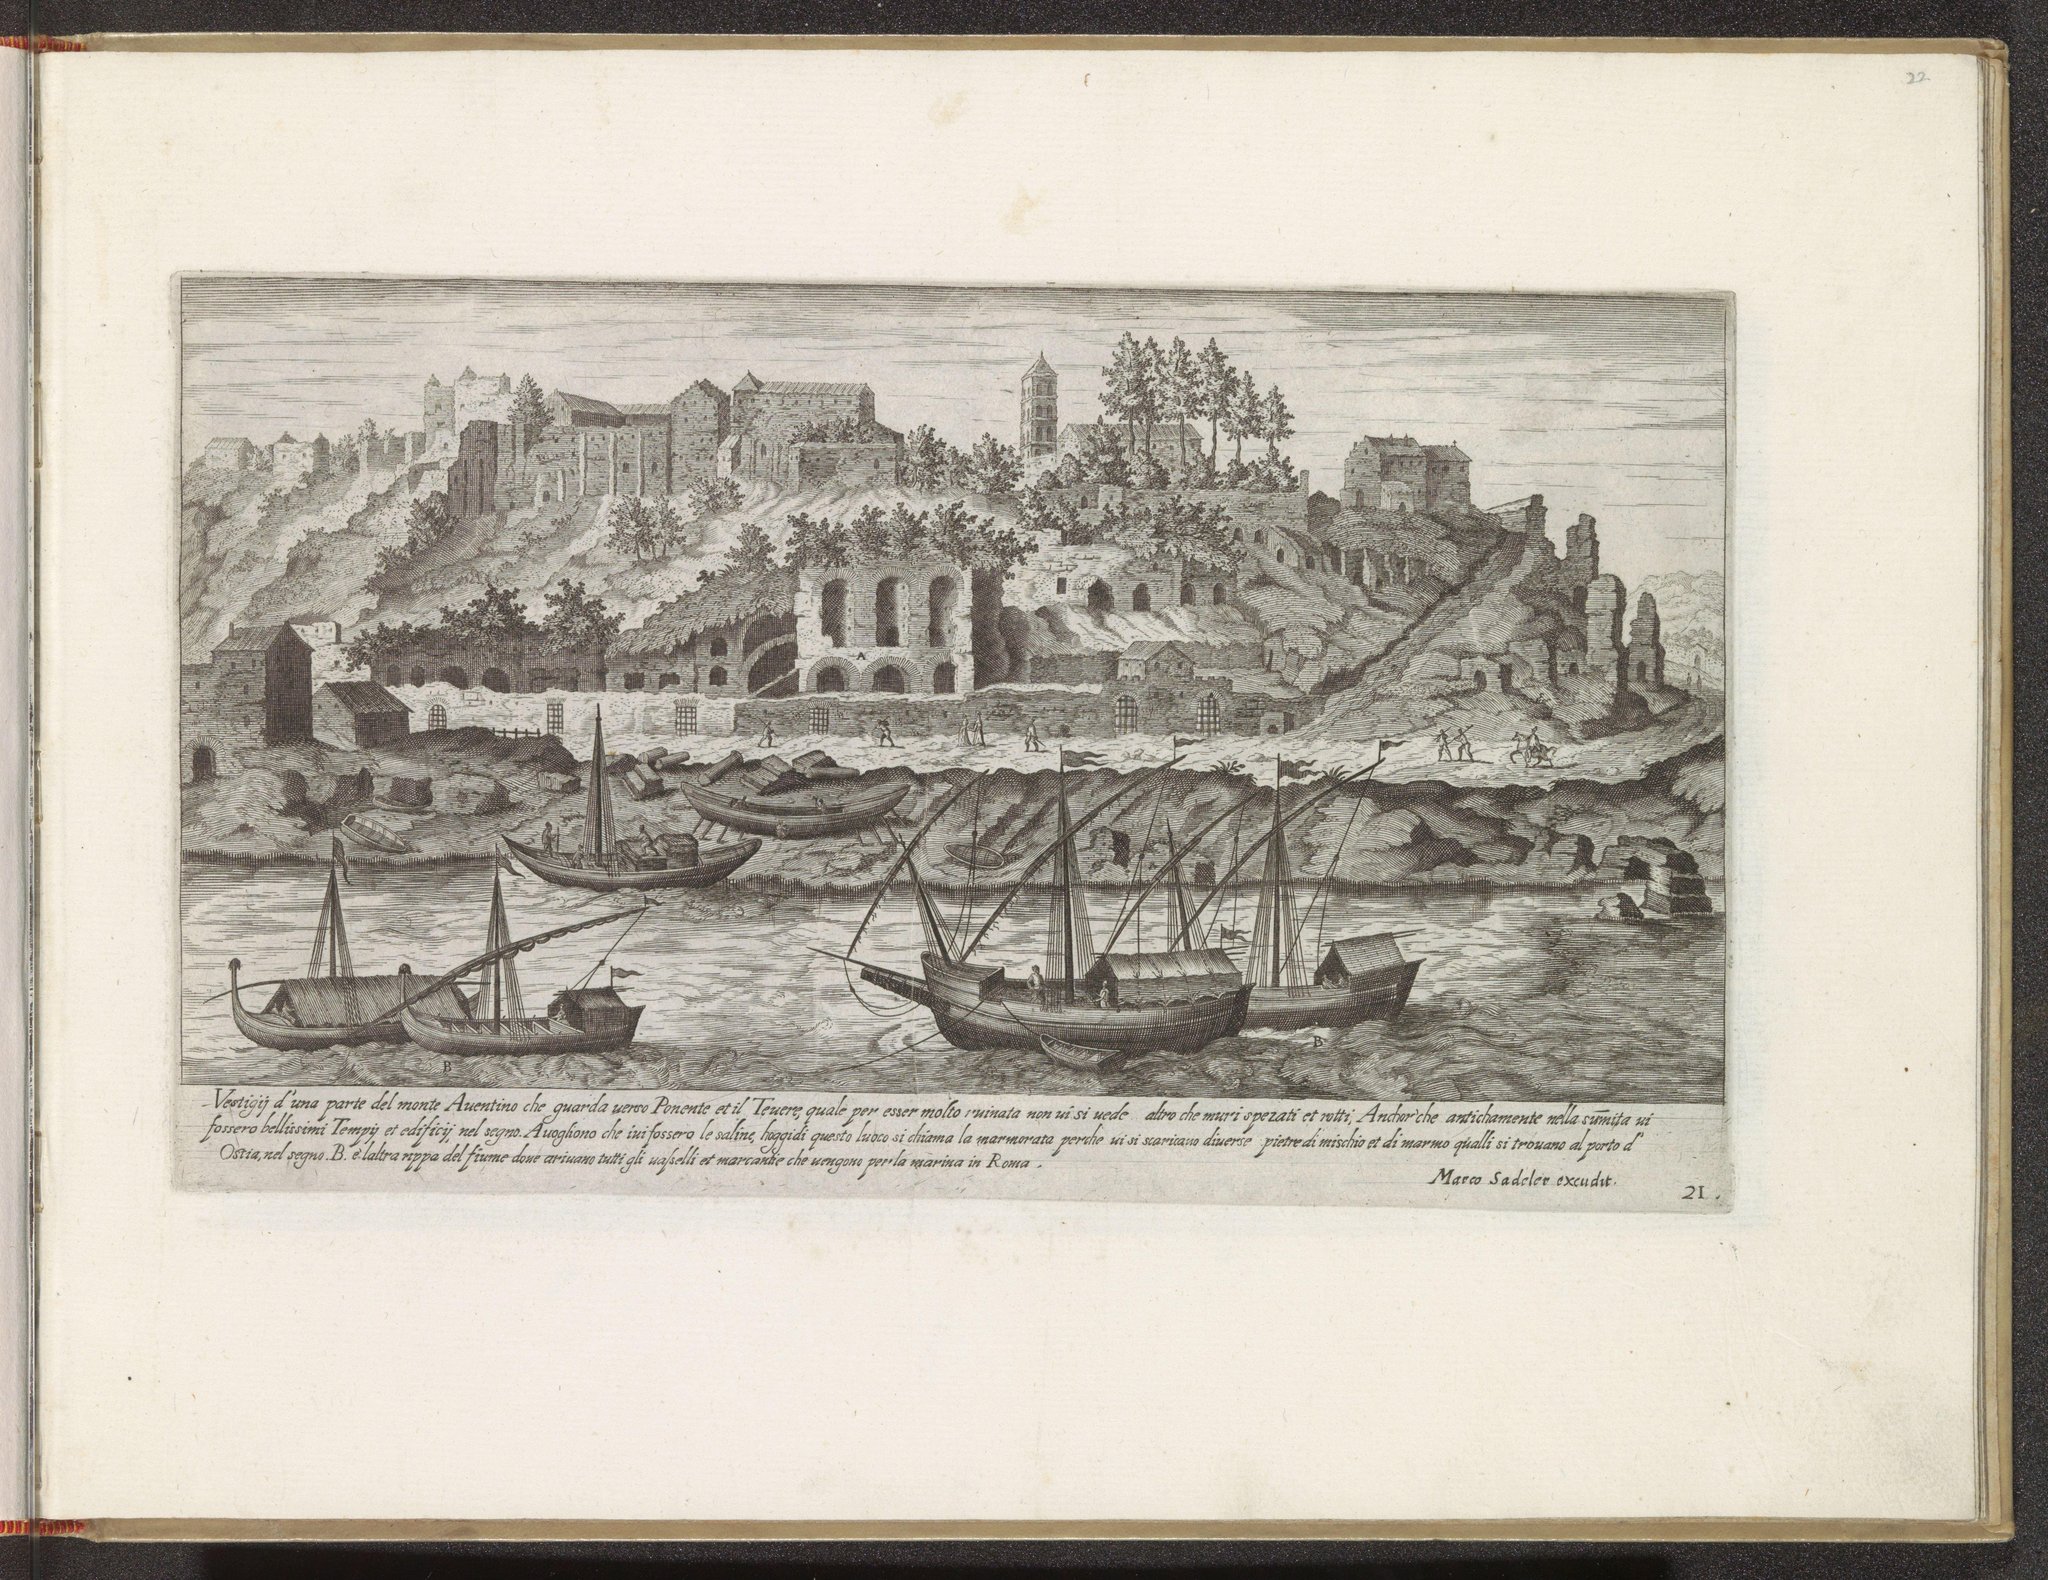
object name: print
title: Vestigi della antichita di Roma, Tivoli, Pozzuolo et altri Luochi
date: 1606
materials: paper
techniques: engraving, etching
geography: prague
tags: rome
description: Overblijfselen van de gebouwen op de Aventijn. Op de voorgrond de rivier de Tiber met schepen. In de ondermarge drie regels tekst in het Italiaans. De prent maakt deel uit van een album.